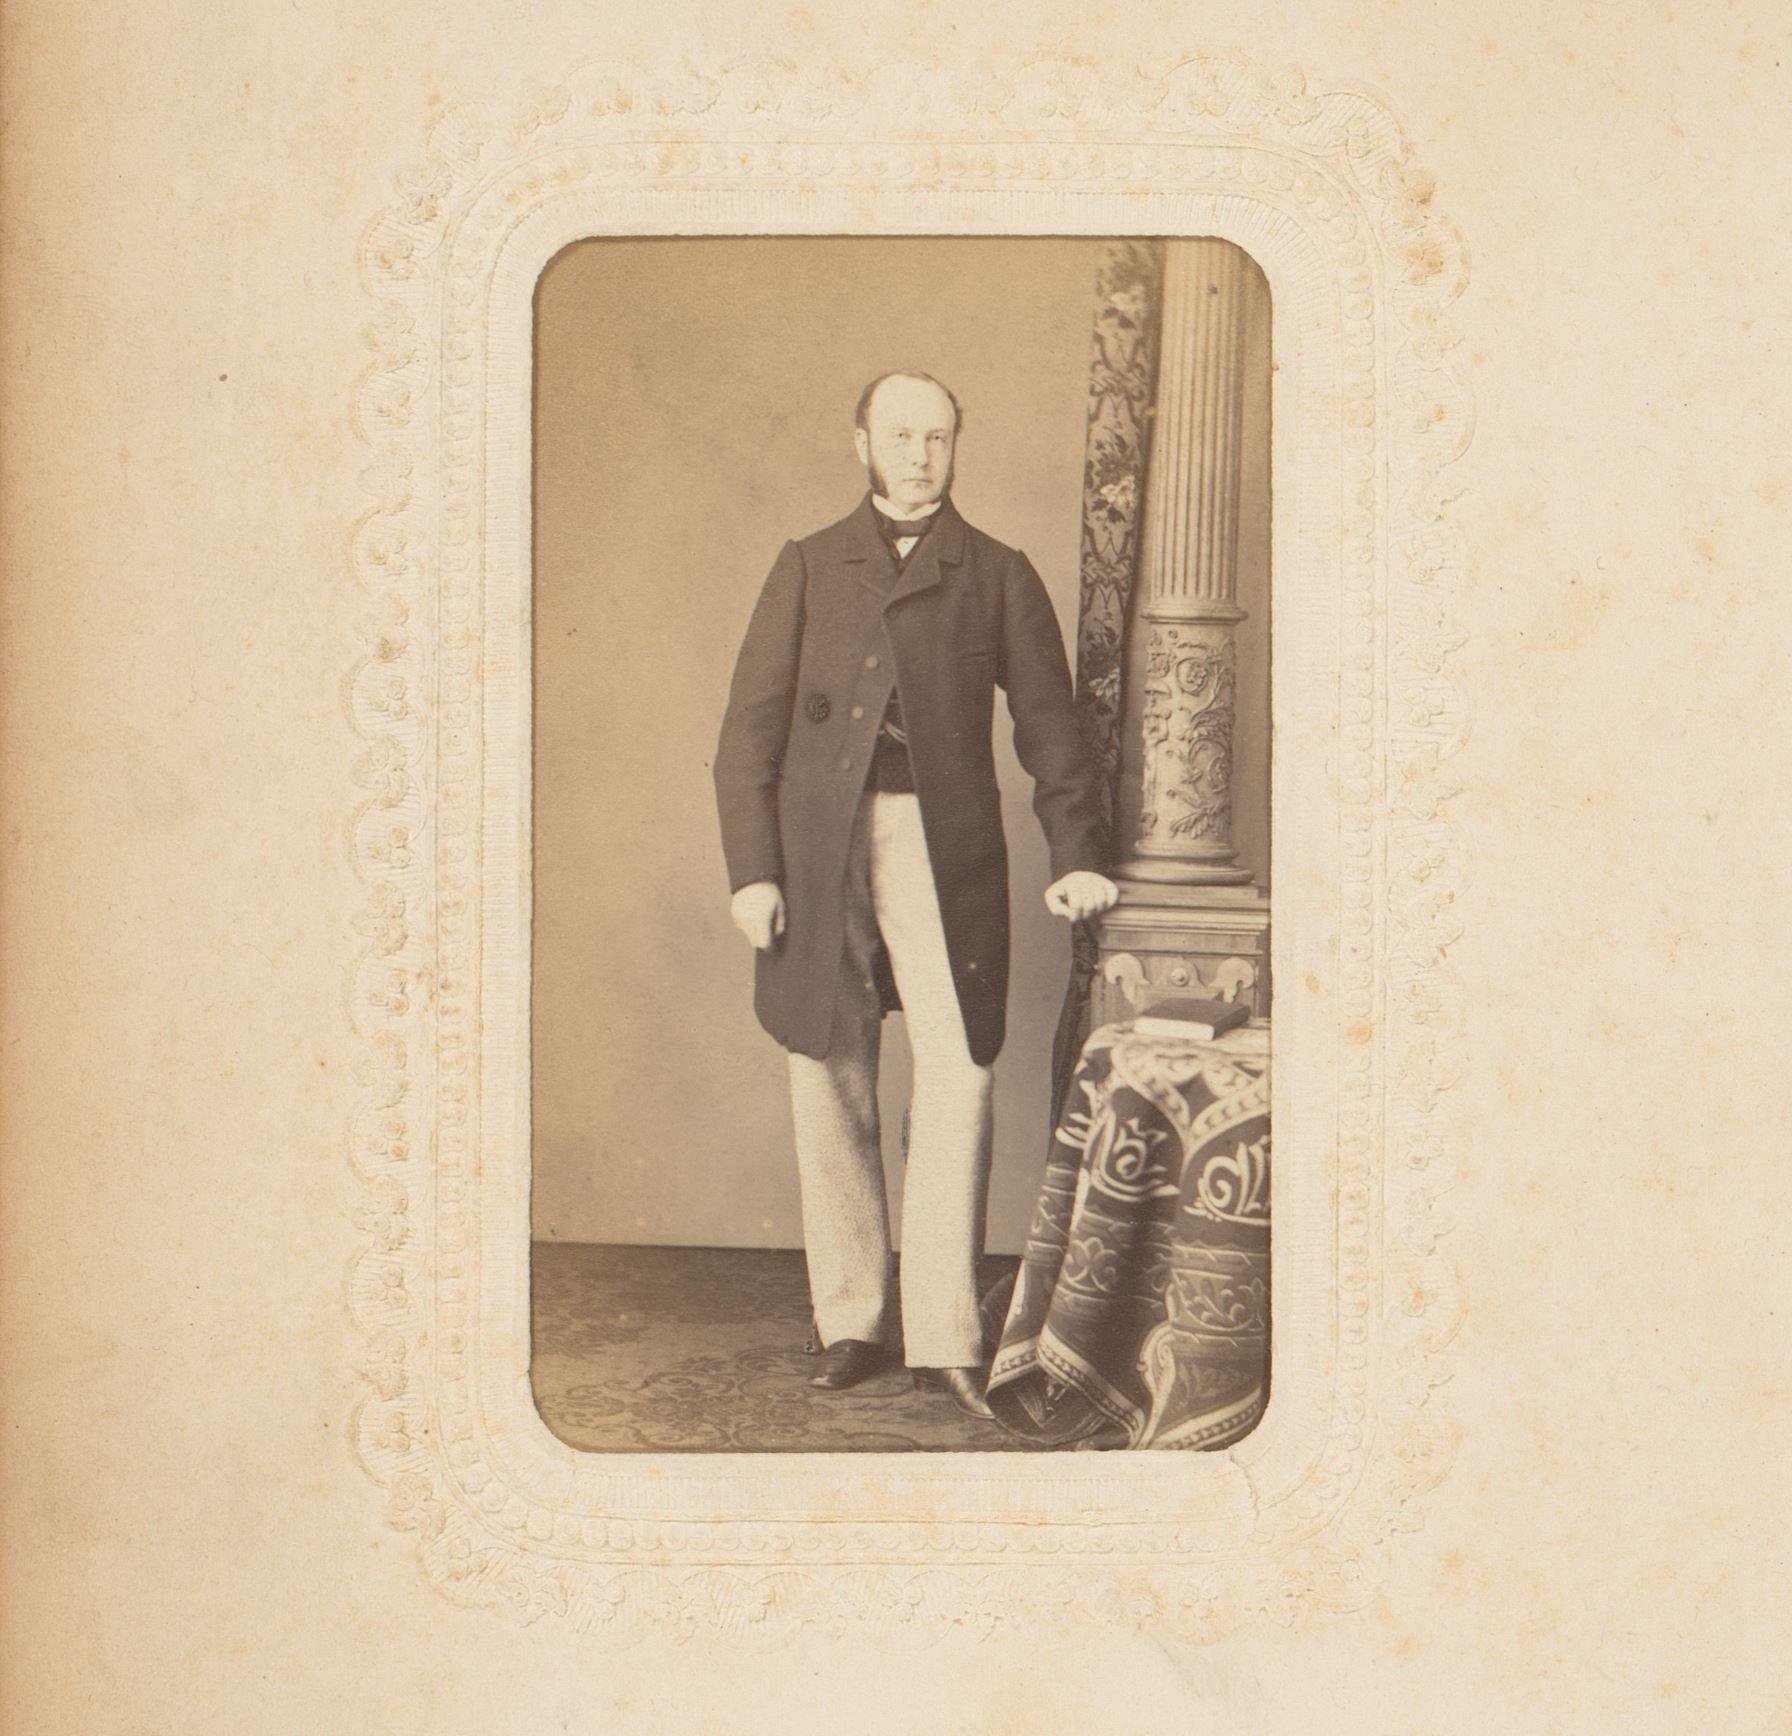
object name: carte de visite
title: Portret van een man, staand bij een zuil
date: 1862-1863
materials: cardboard, photographic support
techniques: albumen print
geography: brussels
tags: standing figure, historical persons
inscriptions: inscription: ‘Etablissement Photographique/ de Maes & Michaux/ Place de la Monnaie, 36, Rue Fossé-aux-Loups/ Bruxelles’